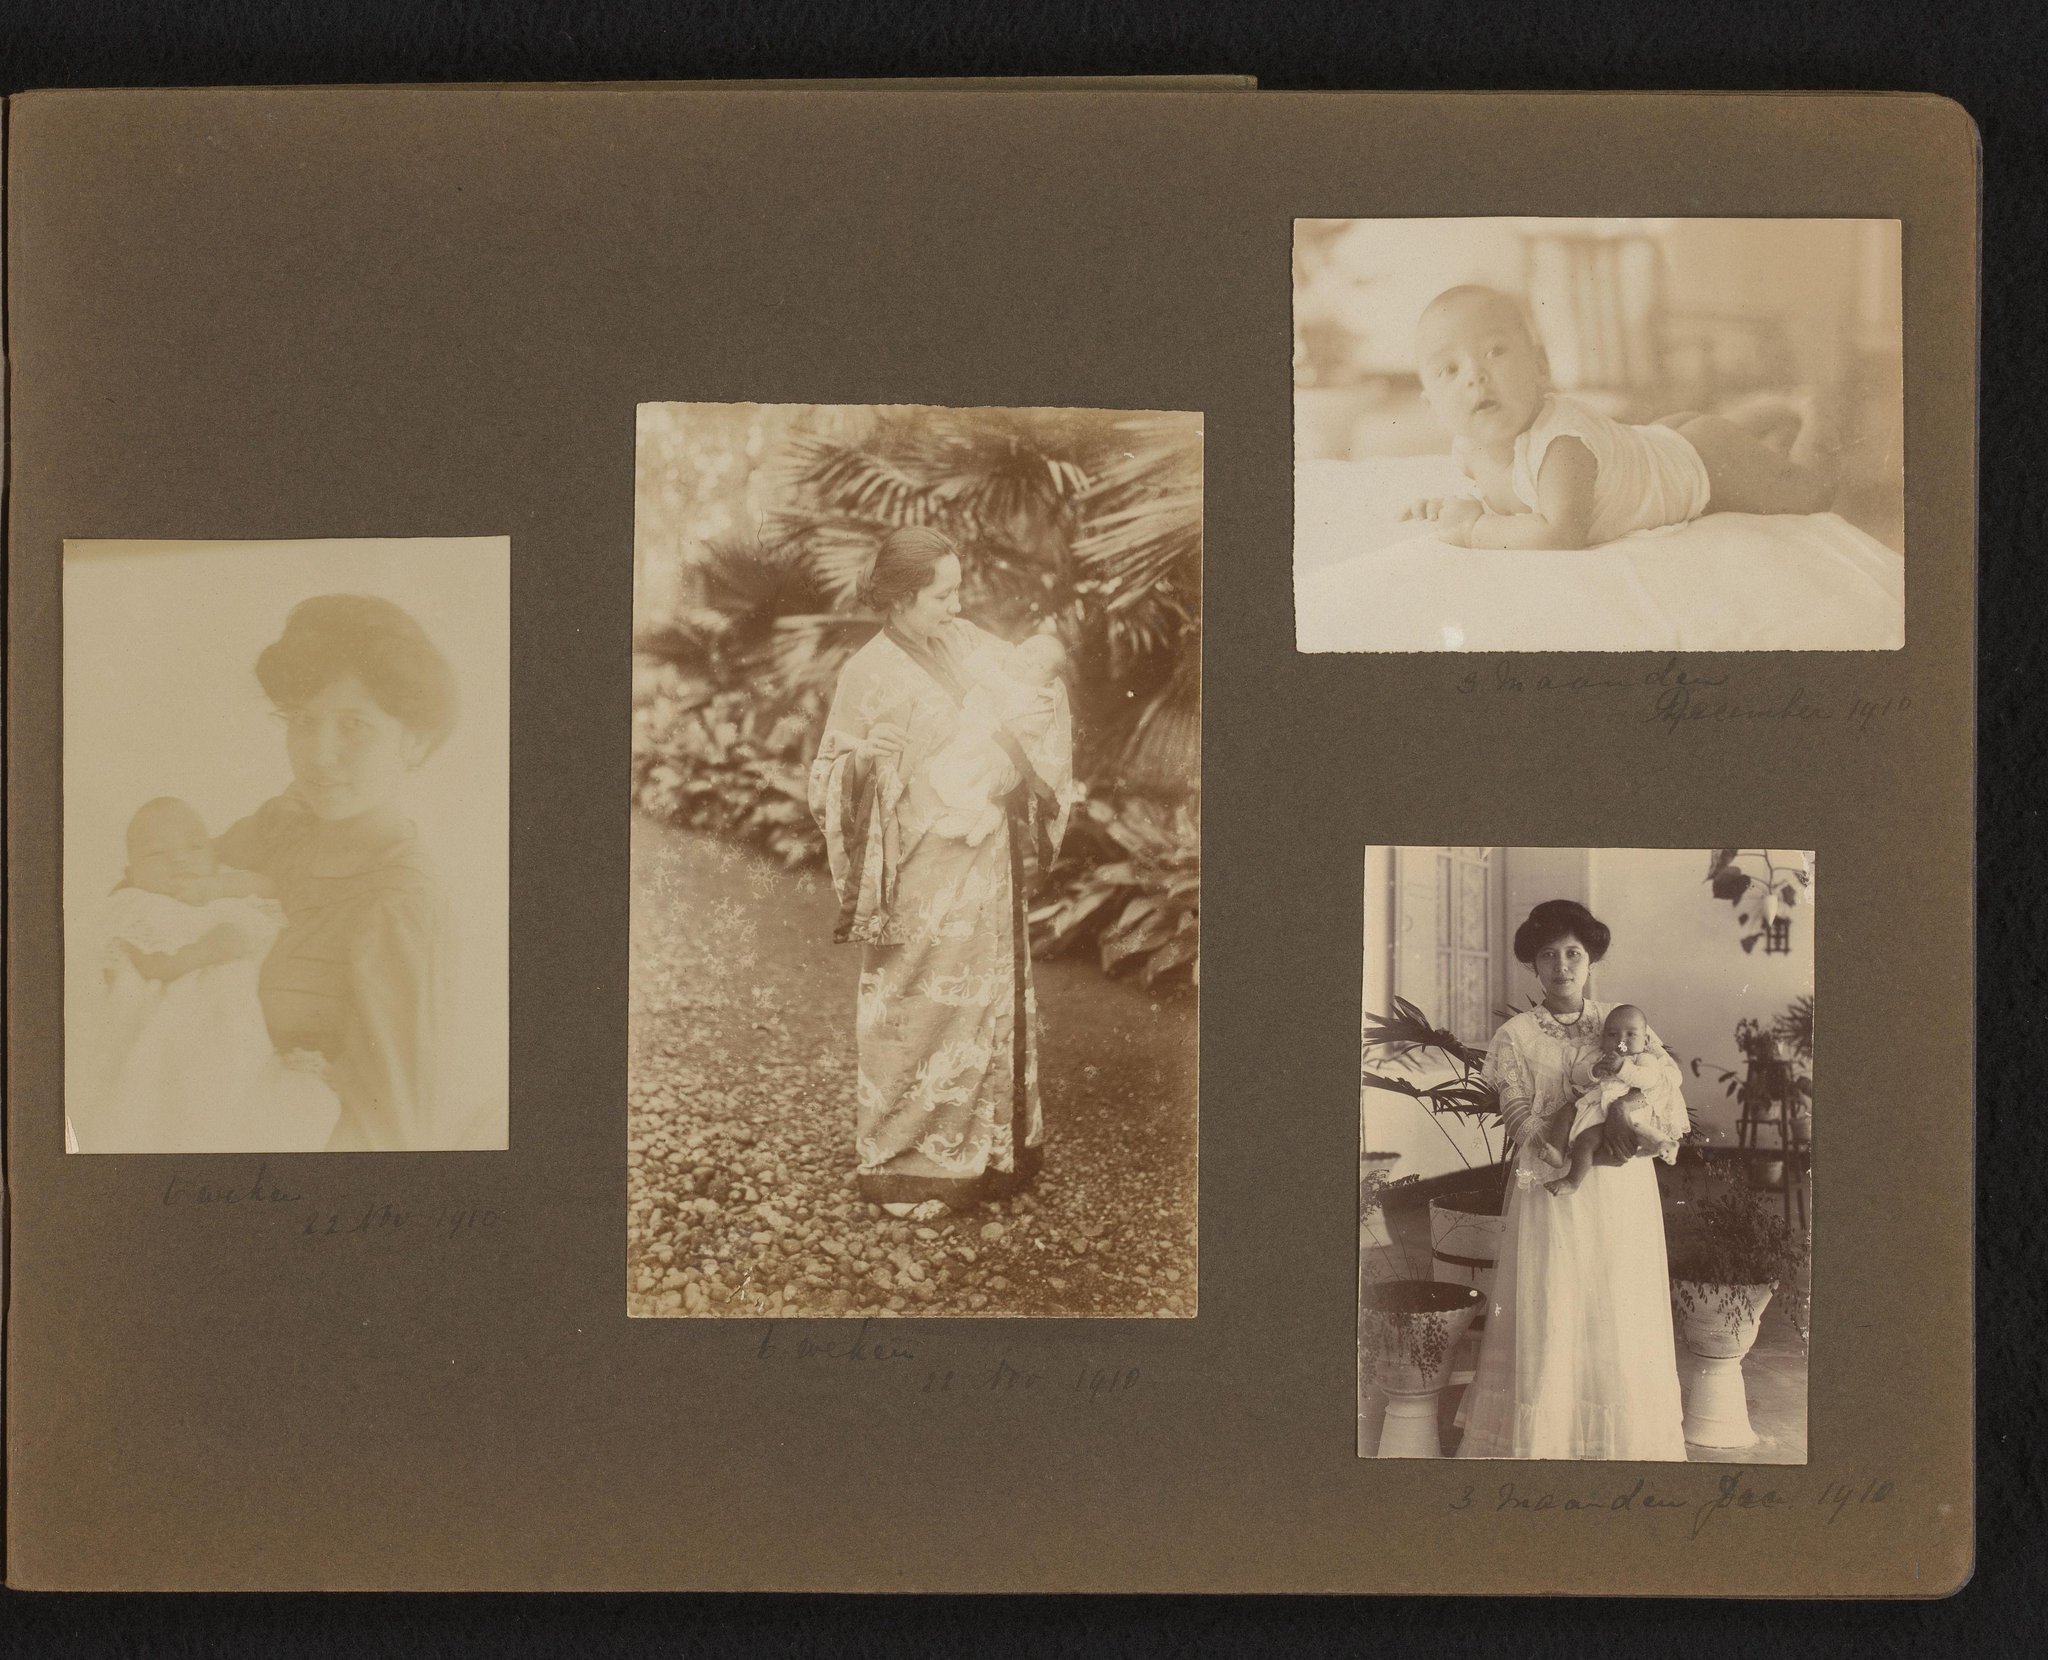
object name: album leaf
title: Vier foto's van baby Han met zijn moeder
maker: frédéric gabriël dumas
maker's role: engineer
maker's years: 1886-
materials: cardboard, photographic support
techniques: collodion silver print, gelatin silver print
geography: dutch east indies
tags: java, male infant, family life at home, dutch east indies, the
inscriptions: annotation: ‘6 weken 22 nov 1910 / 3 maanden December 1910 / 3 maanden Dec. 1910’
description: Blad met vier foto's van baby Han Dumas met zijn moeder. Onderdeel van het fotoalbum over de kindertijd van Han (geboren sept-okt 1910) en Eef Dumas (geboren februari 1915) in Nederlands-Indië.